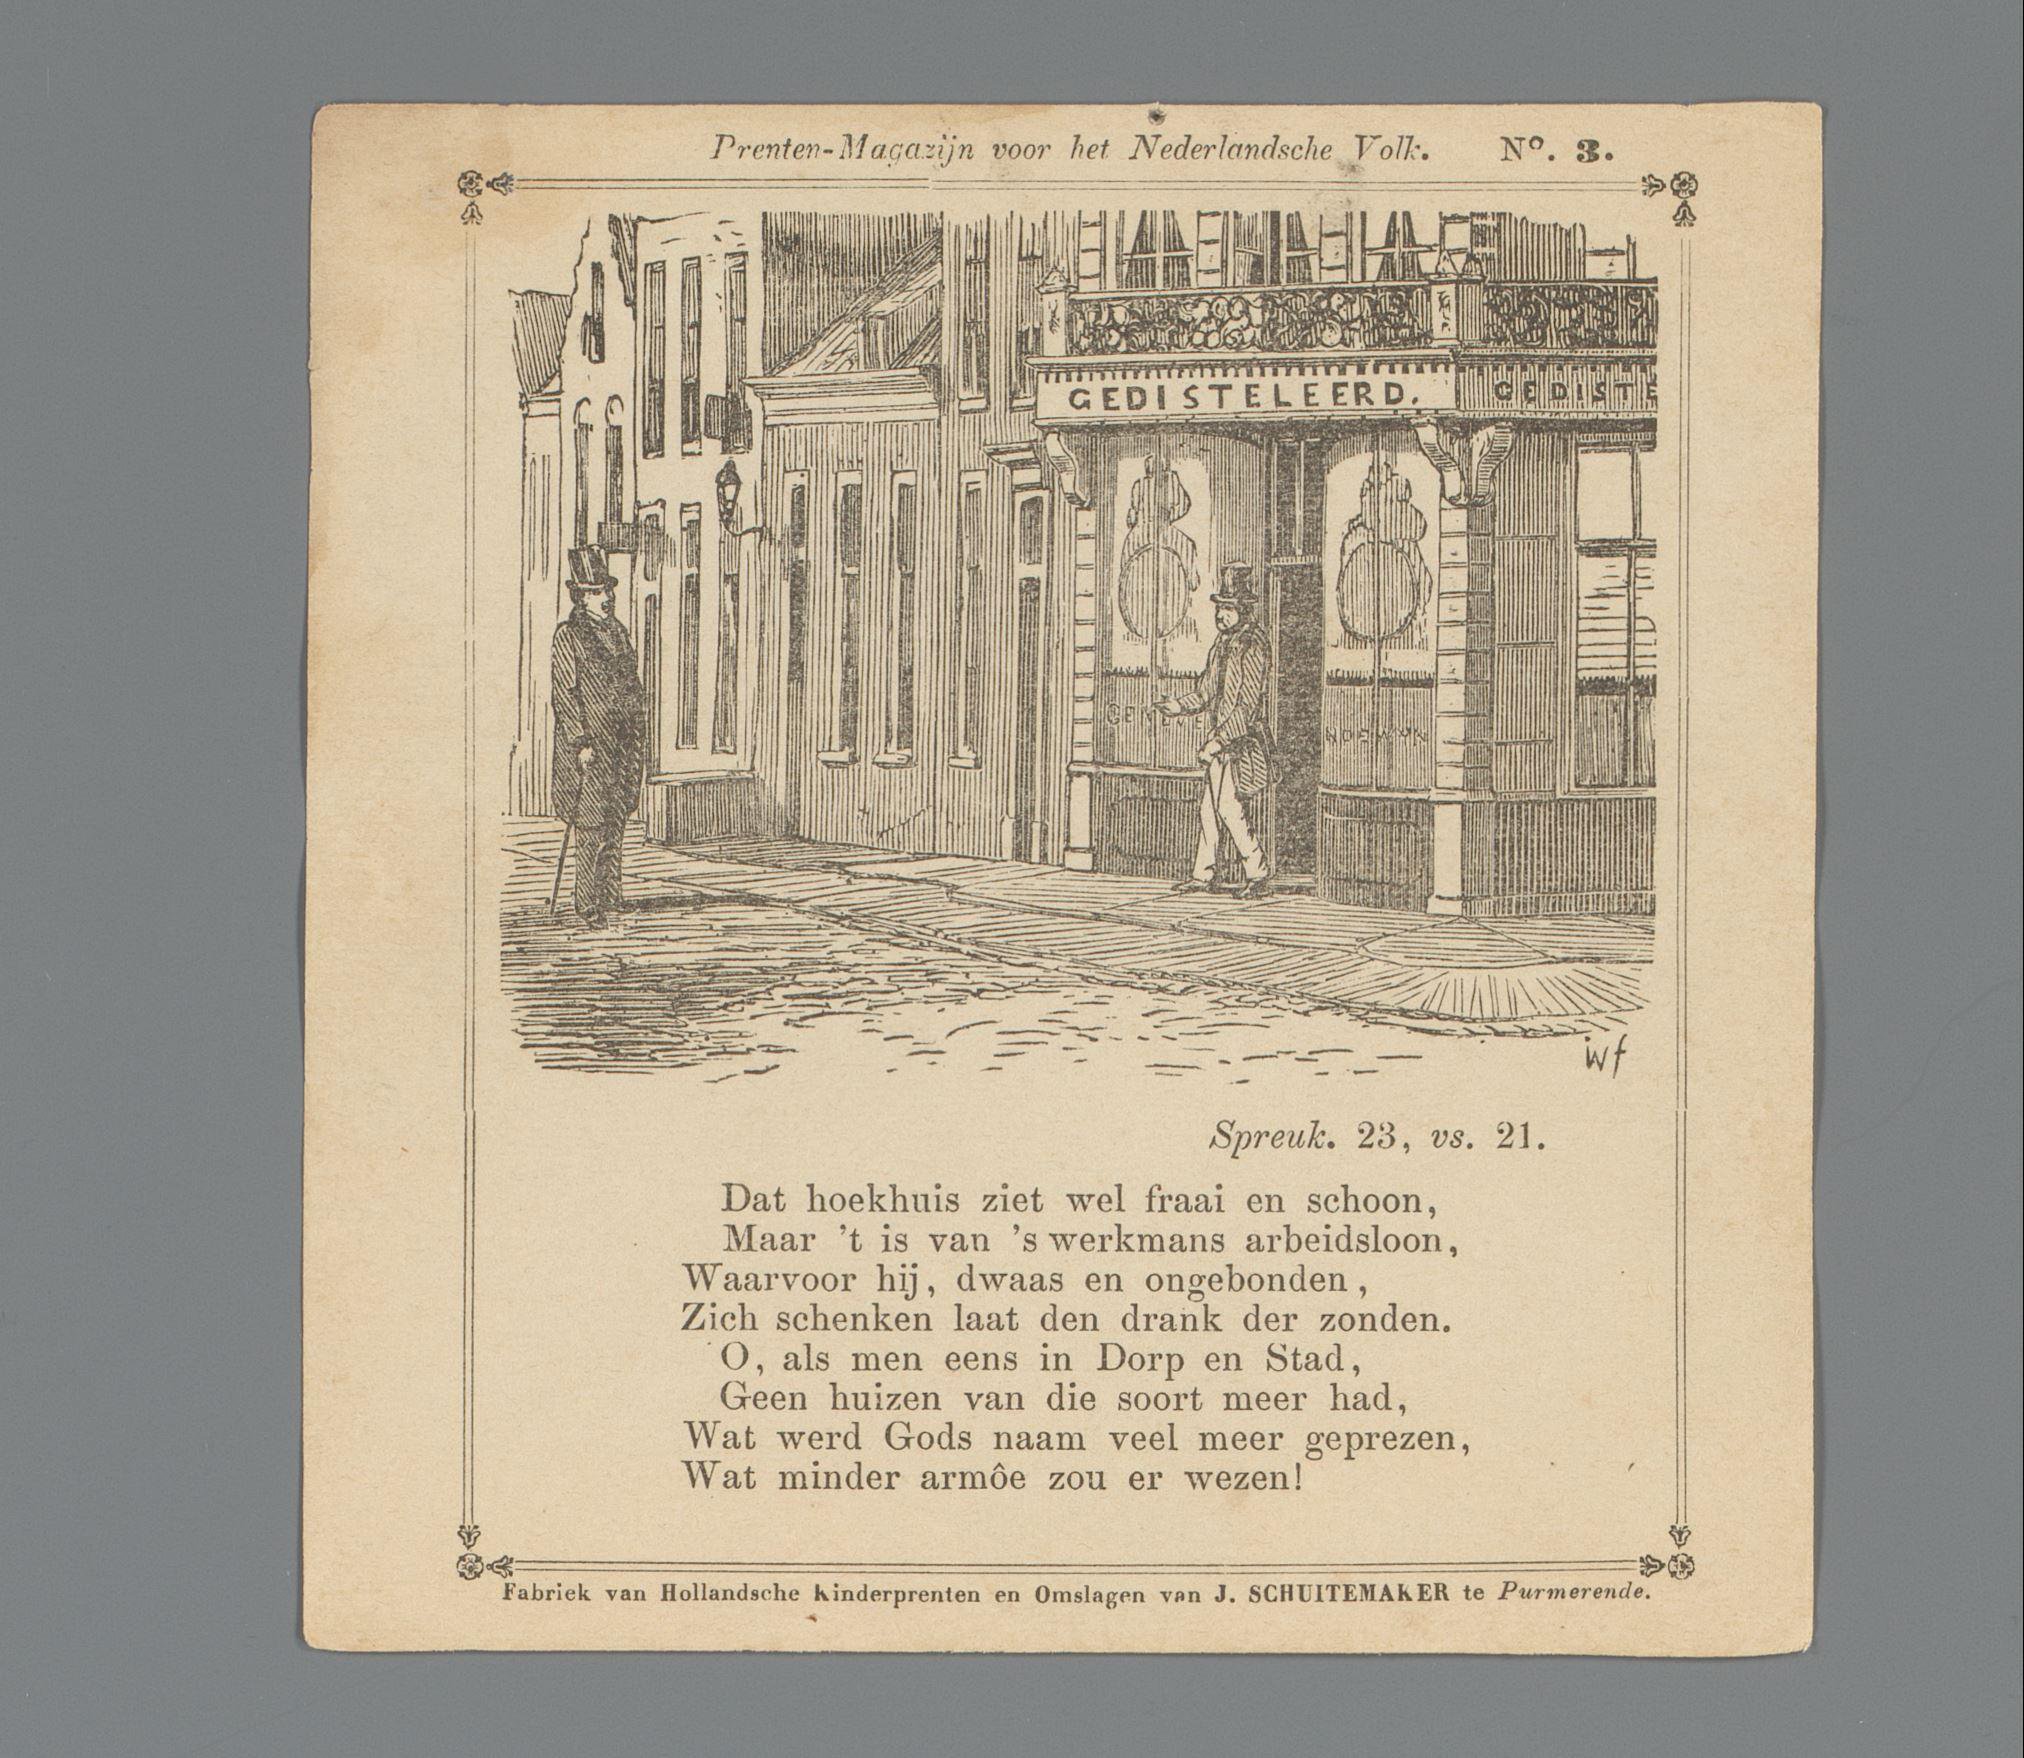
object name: print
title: Man op straat ziet een andere man uit een winkel voor gedestilleerde drank komen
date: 1838-1912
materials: paper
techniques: letterpress printing, engraving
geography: netherlands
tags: genever, gin, alcoholism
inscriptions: collector's mark: Lugt 2228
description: Prent uit een serie van twaalf over het afschaffen van sterke drank. Onder de afbeelding een kort gedicht. Boven de afbeelding de regel: 'Prenten-Magazijn voor het Nederlandsche Volk'.